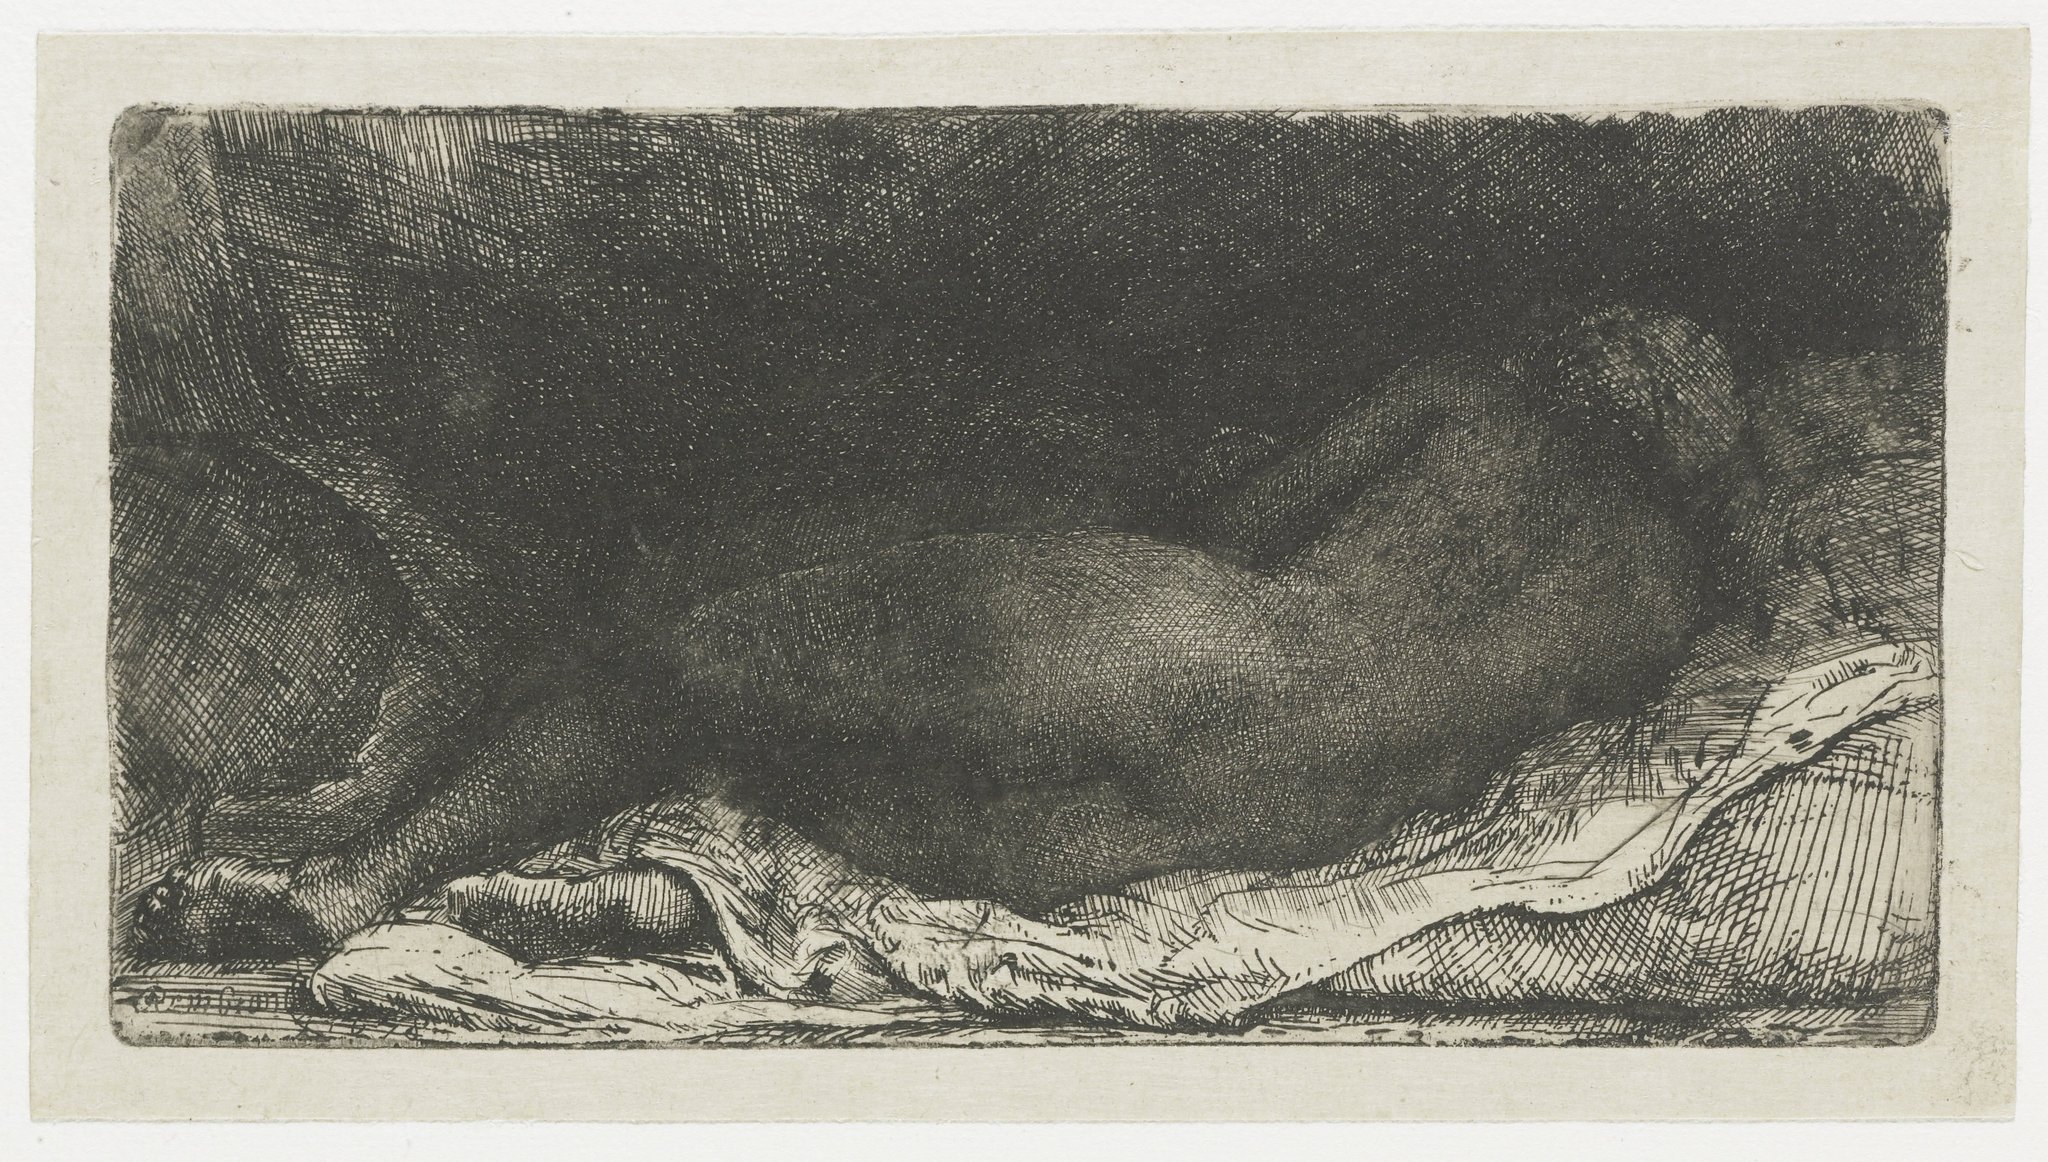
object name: print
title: Reclining female nude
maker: rembrandt van rijn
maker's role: draughtsman, painter, print maker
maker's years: 1606-1669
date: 1658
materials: paper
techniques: drypoint, etching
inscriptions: signature and date: ‘Rembrandt f 1658’, collector's mark: Lugt 240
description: Liggende naakte vrouw, op de rug gezien, in het donker.